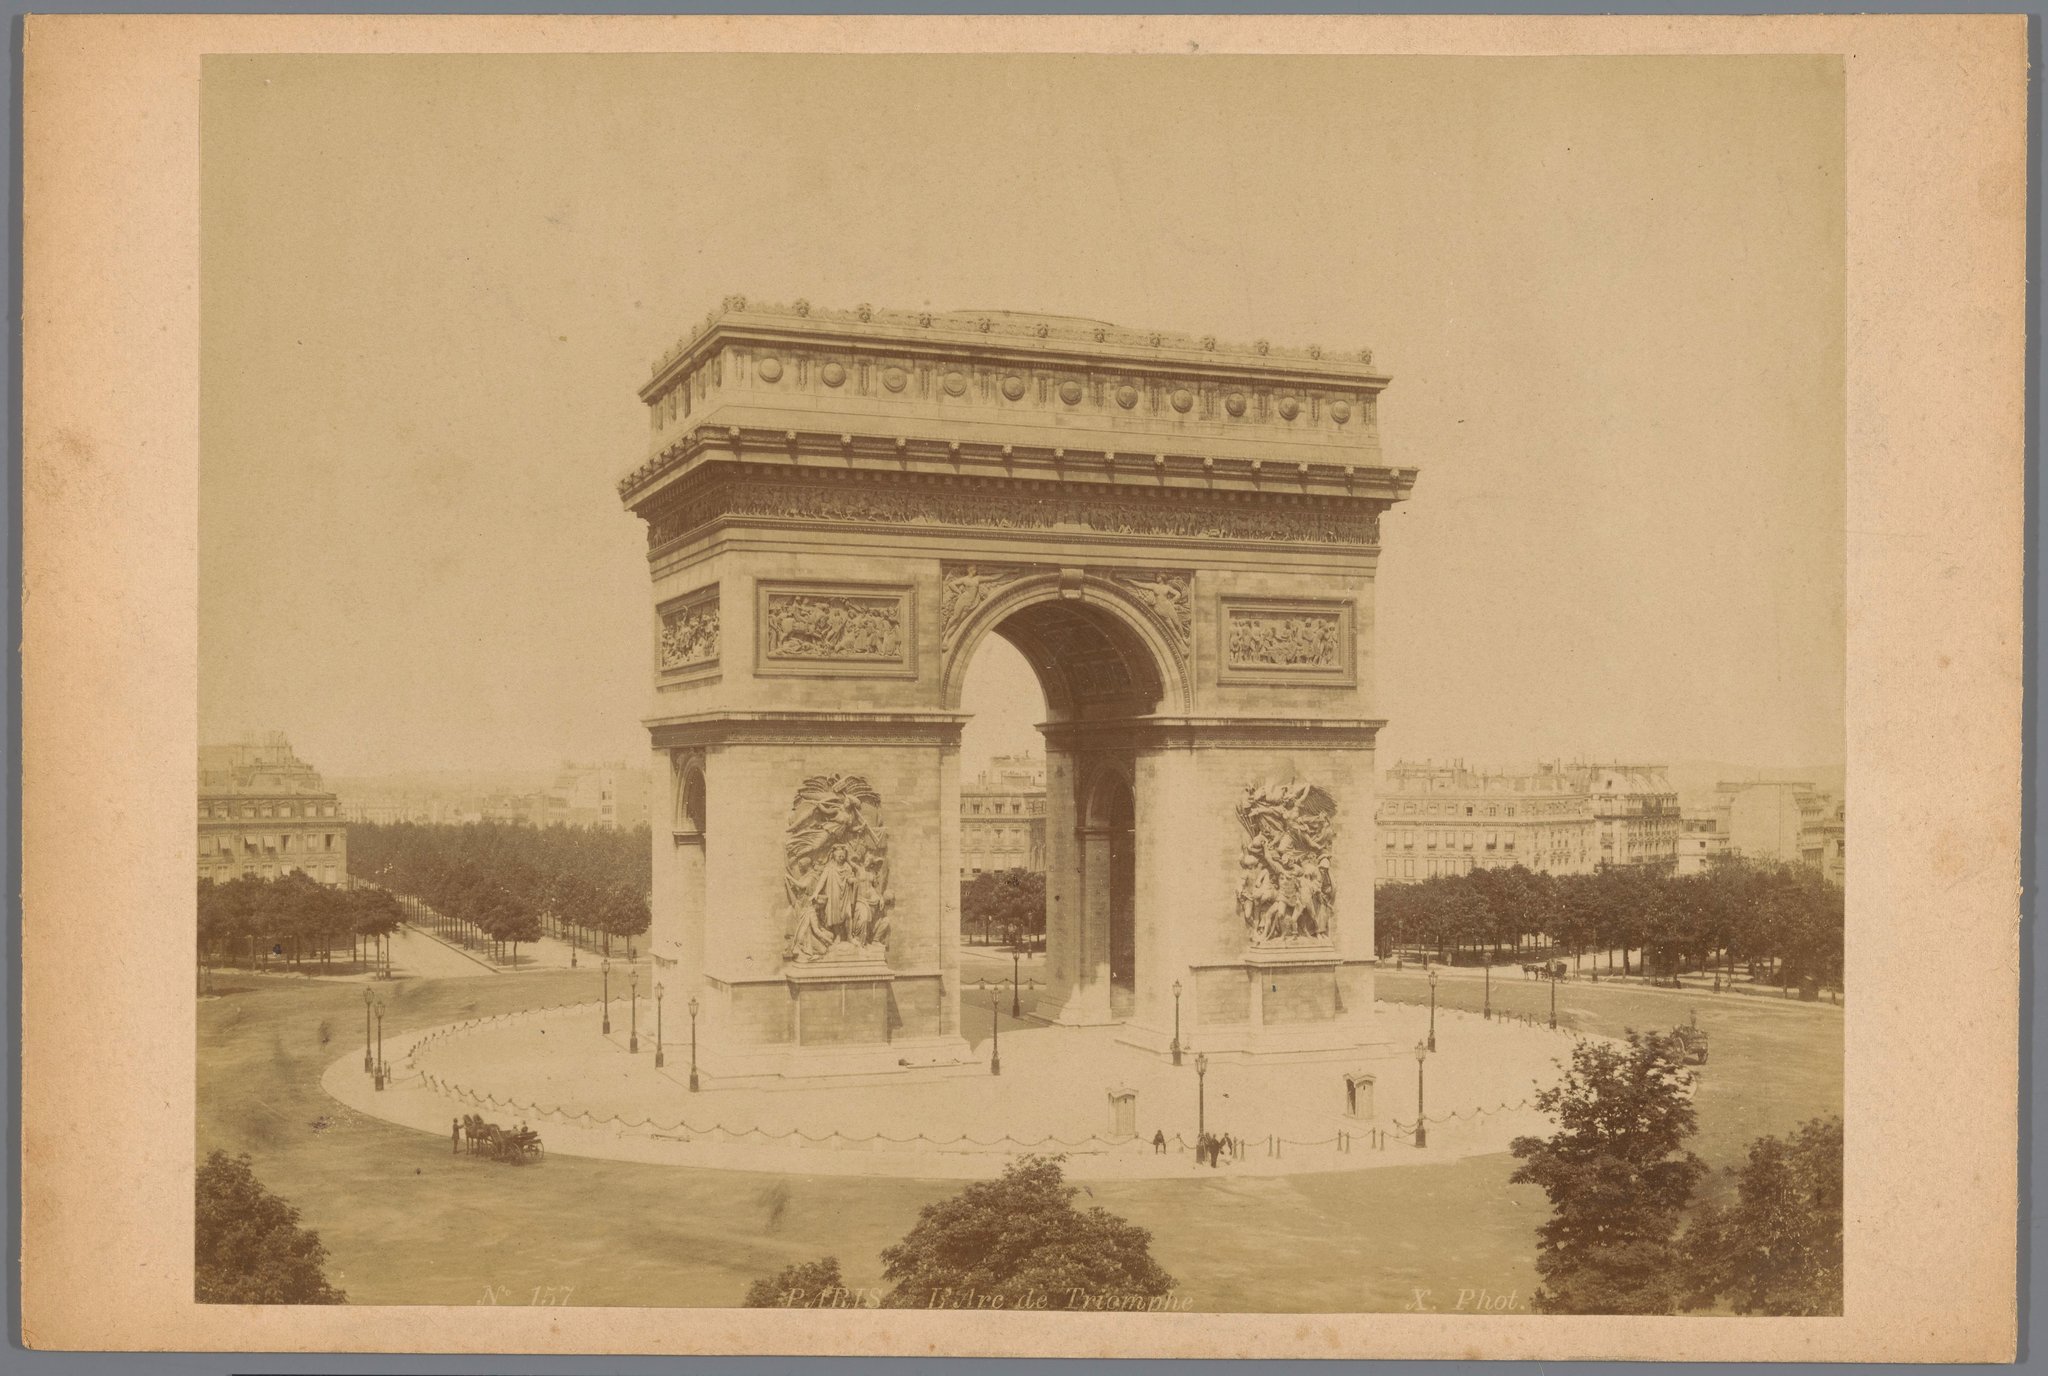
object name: photograph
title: Paris. L' Arc de Triomphe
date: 1887-1900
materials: cardboard, paper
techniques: albumen print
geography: paris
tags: square, place, circus, etc., triumphal arch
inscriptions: inscription: ‘No 157 Paris. L' Arc de Triomphe X. Phot.’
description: Tussen 1887 en ca. 1900 werkten Neurdein frères onder andere onder de naam 'X phot.'.